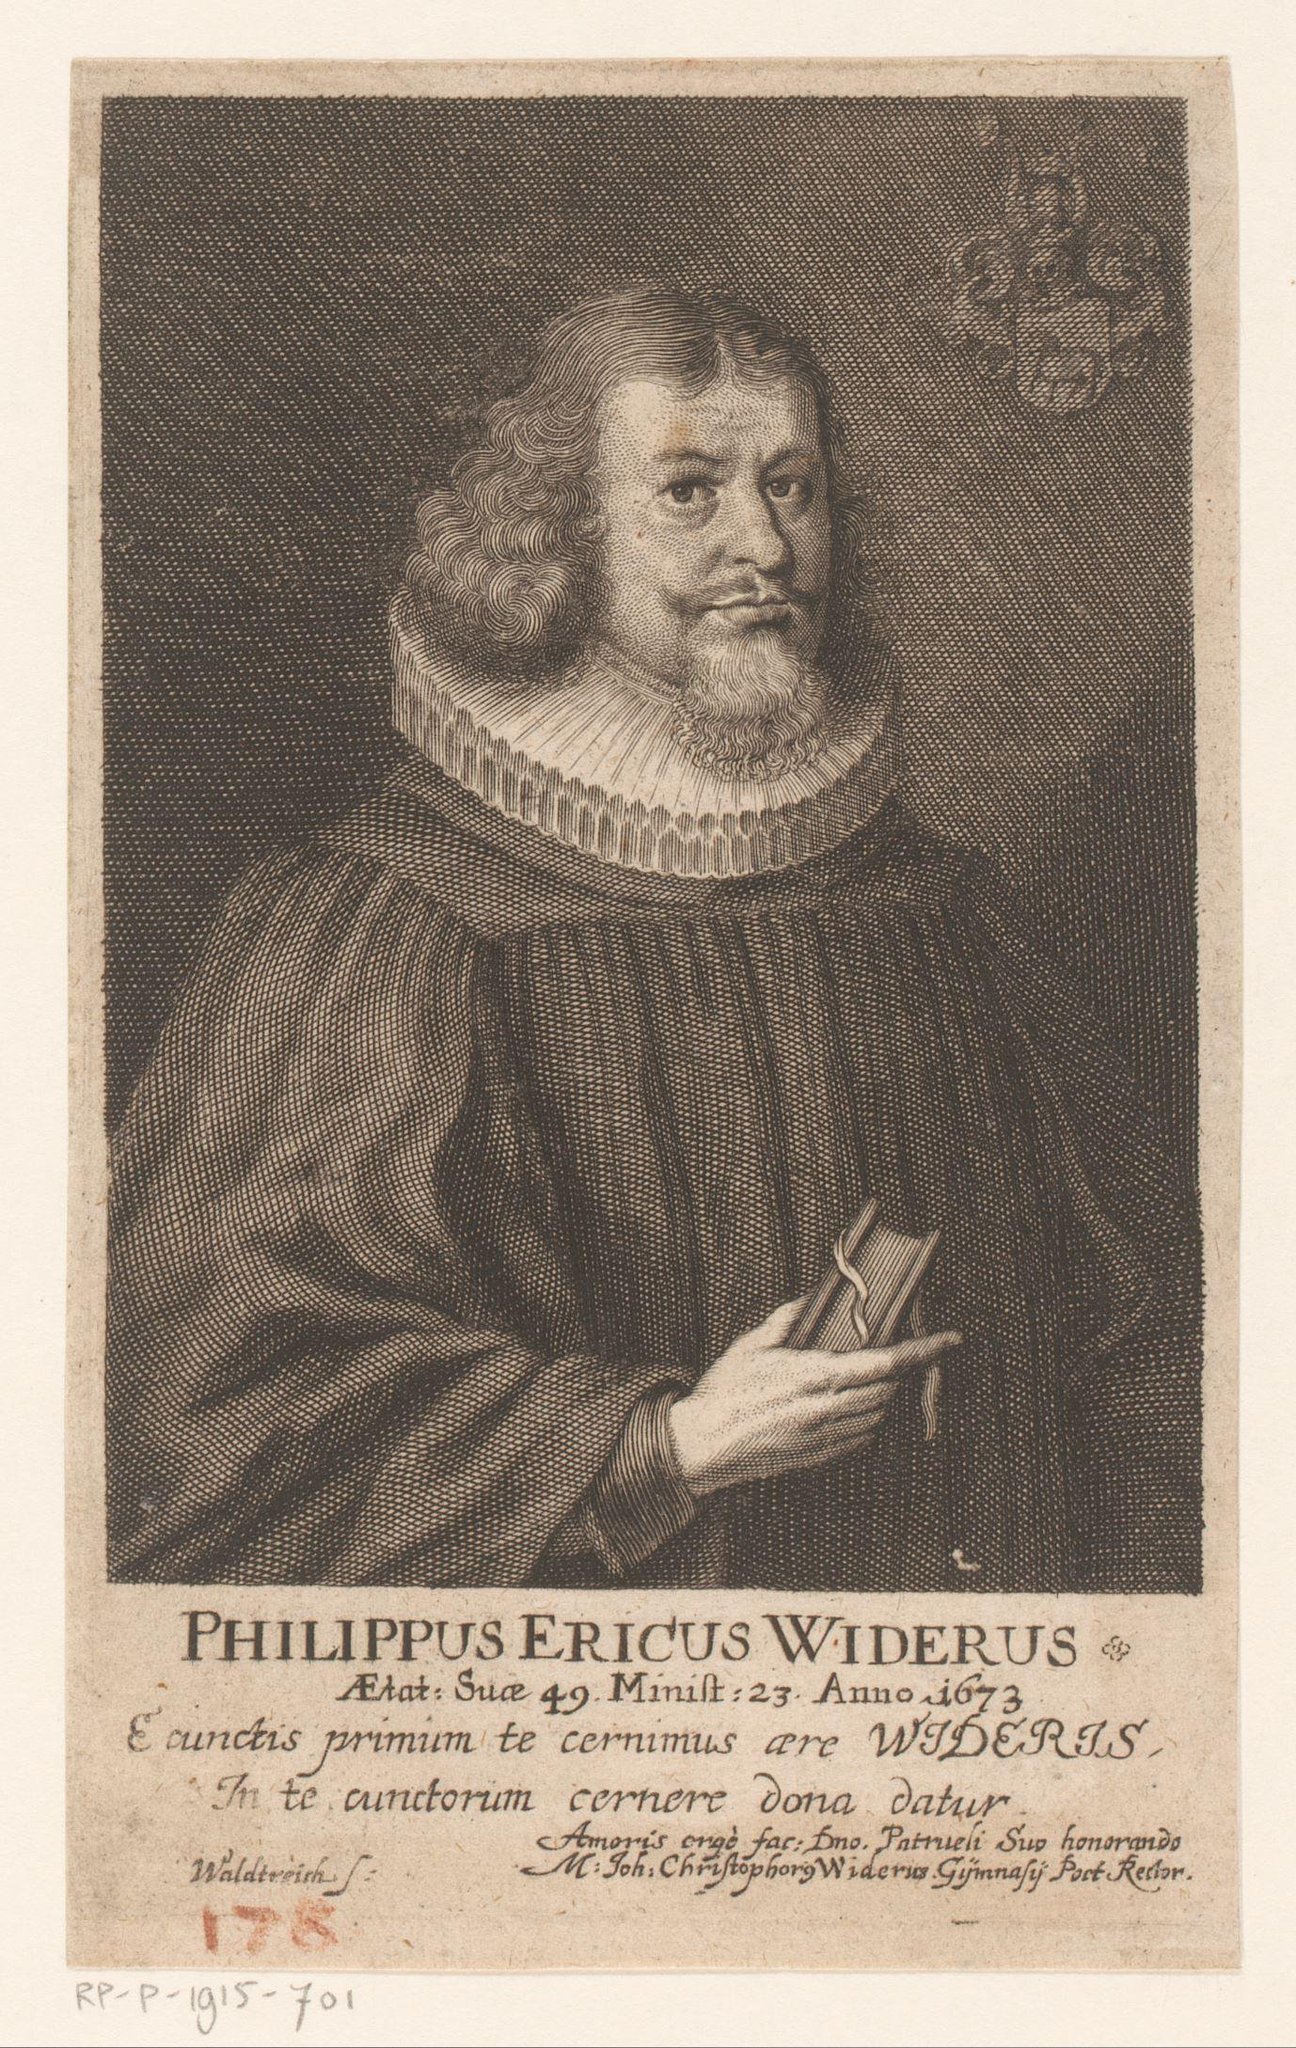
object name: print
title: Portret van Philipp Ehrenreich Wider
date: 1673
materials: paper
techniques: engraving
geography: germany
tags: philipp ehrenreich wider, historical persons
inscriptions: number: ‘178’, collector's mark: Lugt 2228